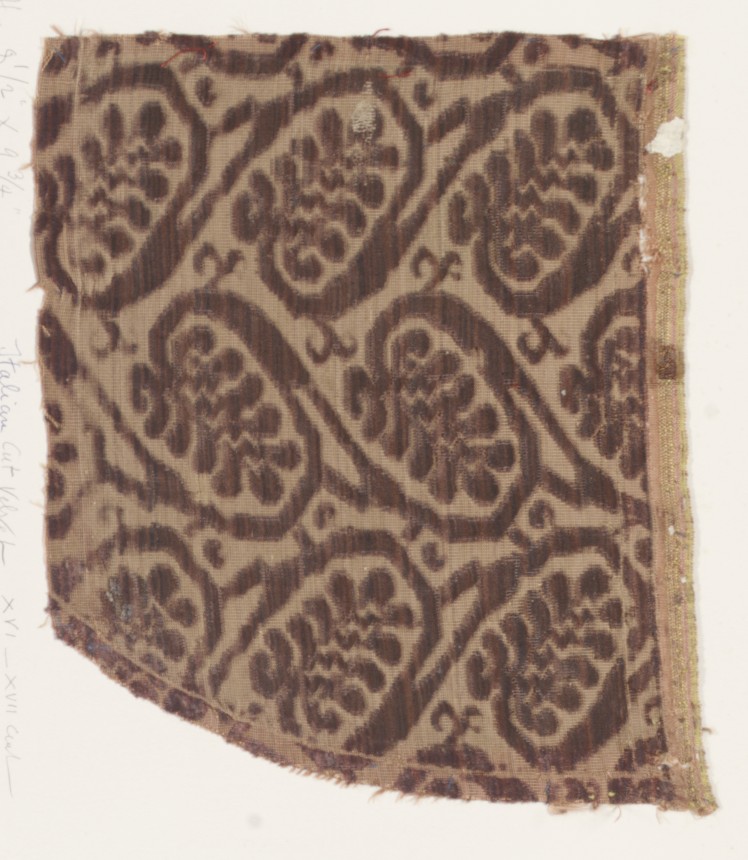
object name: fragment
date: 1501-1700